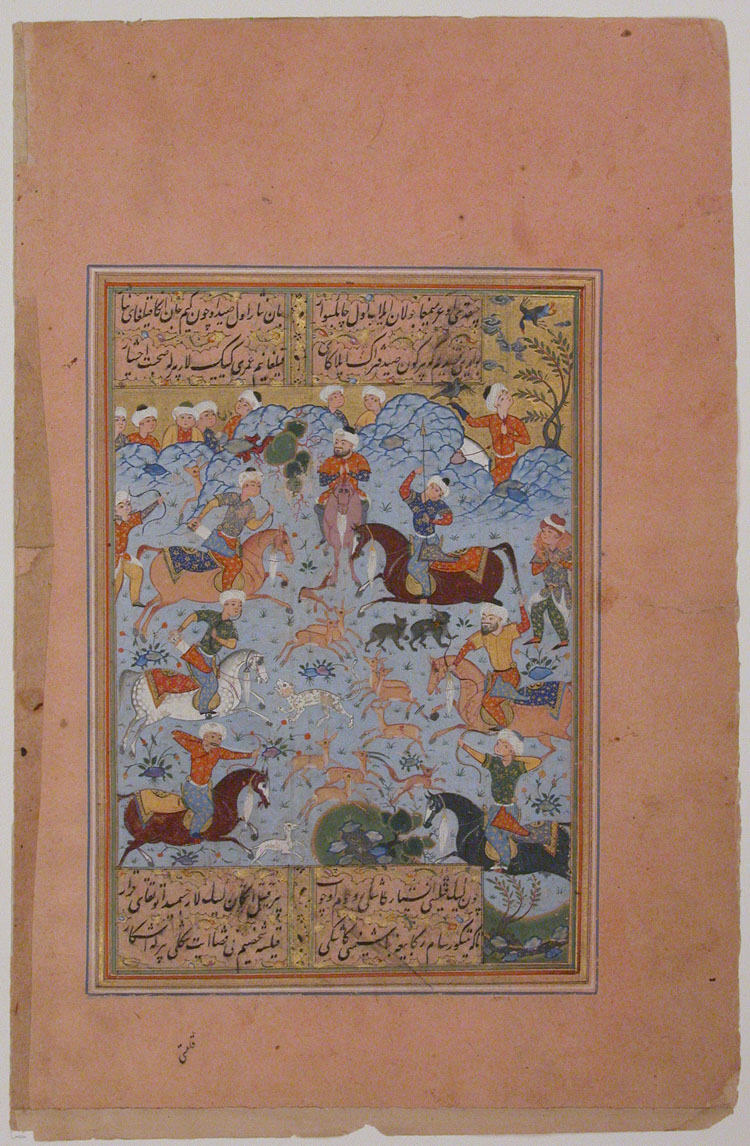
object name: folio from an illustrated manuscript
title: "Hunting Scene", Folio from a Divan (Collected Works) of Mir 'Ali Shir Nava'i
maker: mir 'ali shir nava'i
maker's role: author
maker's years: 1416-1476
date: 1580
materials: gold, ink, paper, watercolor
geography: iran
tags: animals,men,hunting,horses